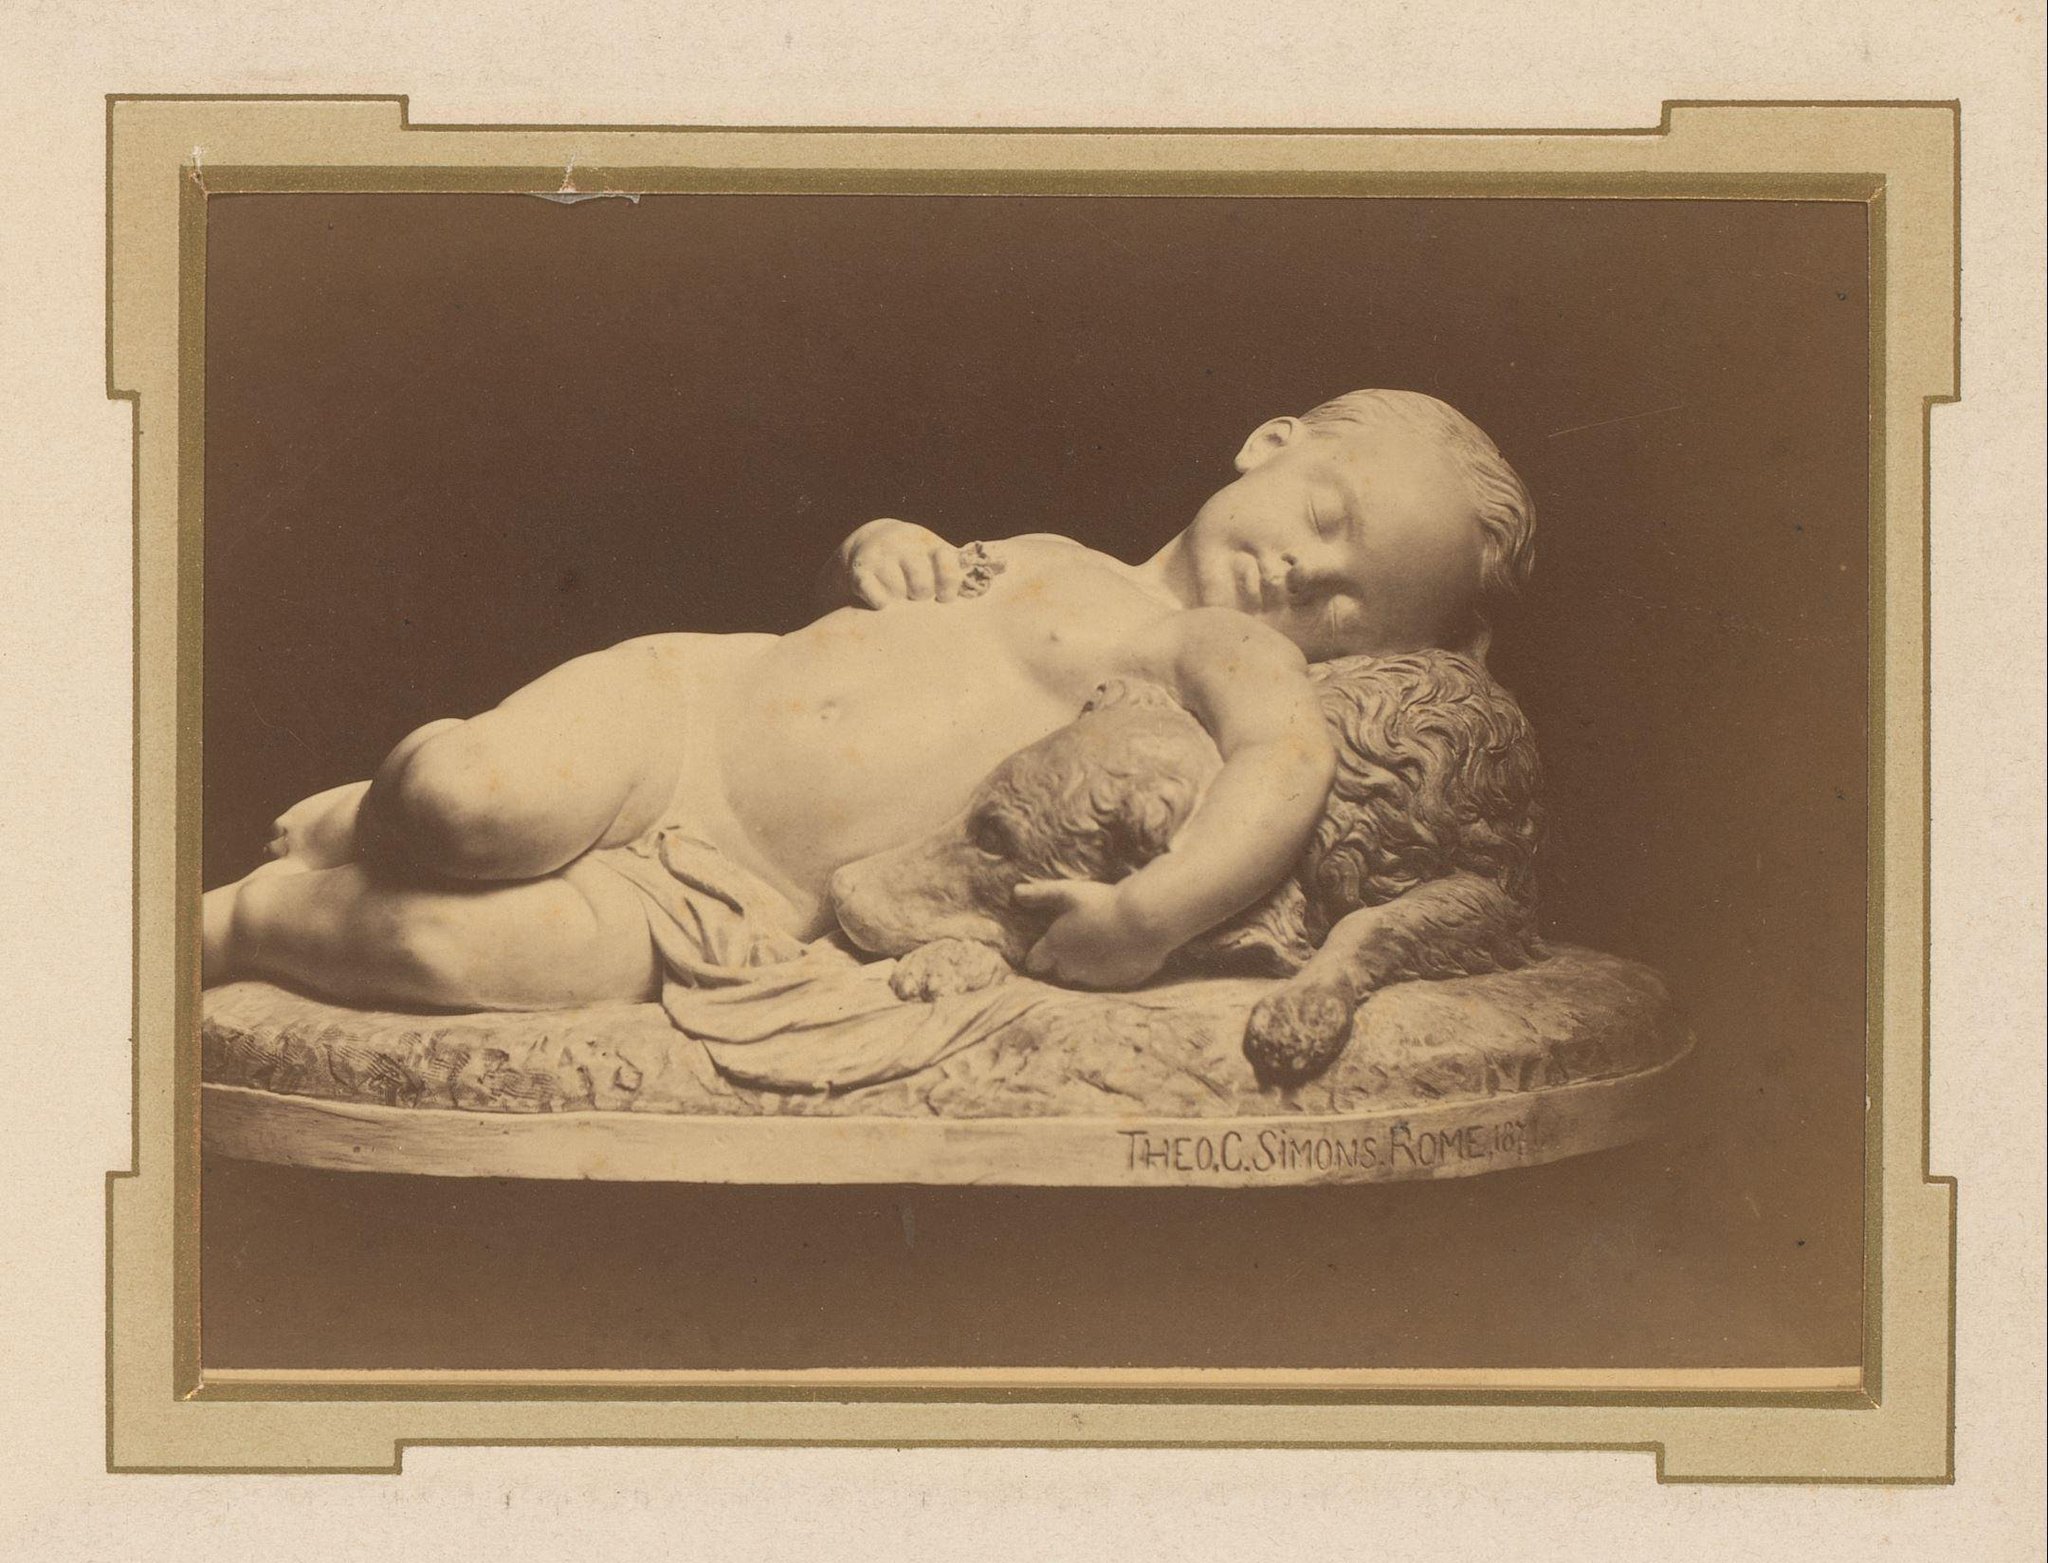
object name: photograph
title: Sculptuur van een slapend kind met hond van Theo Simons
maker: Anonymous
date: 1870-1900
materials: cardboard, photographic support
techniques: albumen print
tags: child, sleeping on the ground, dog